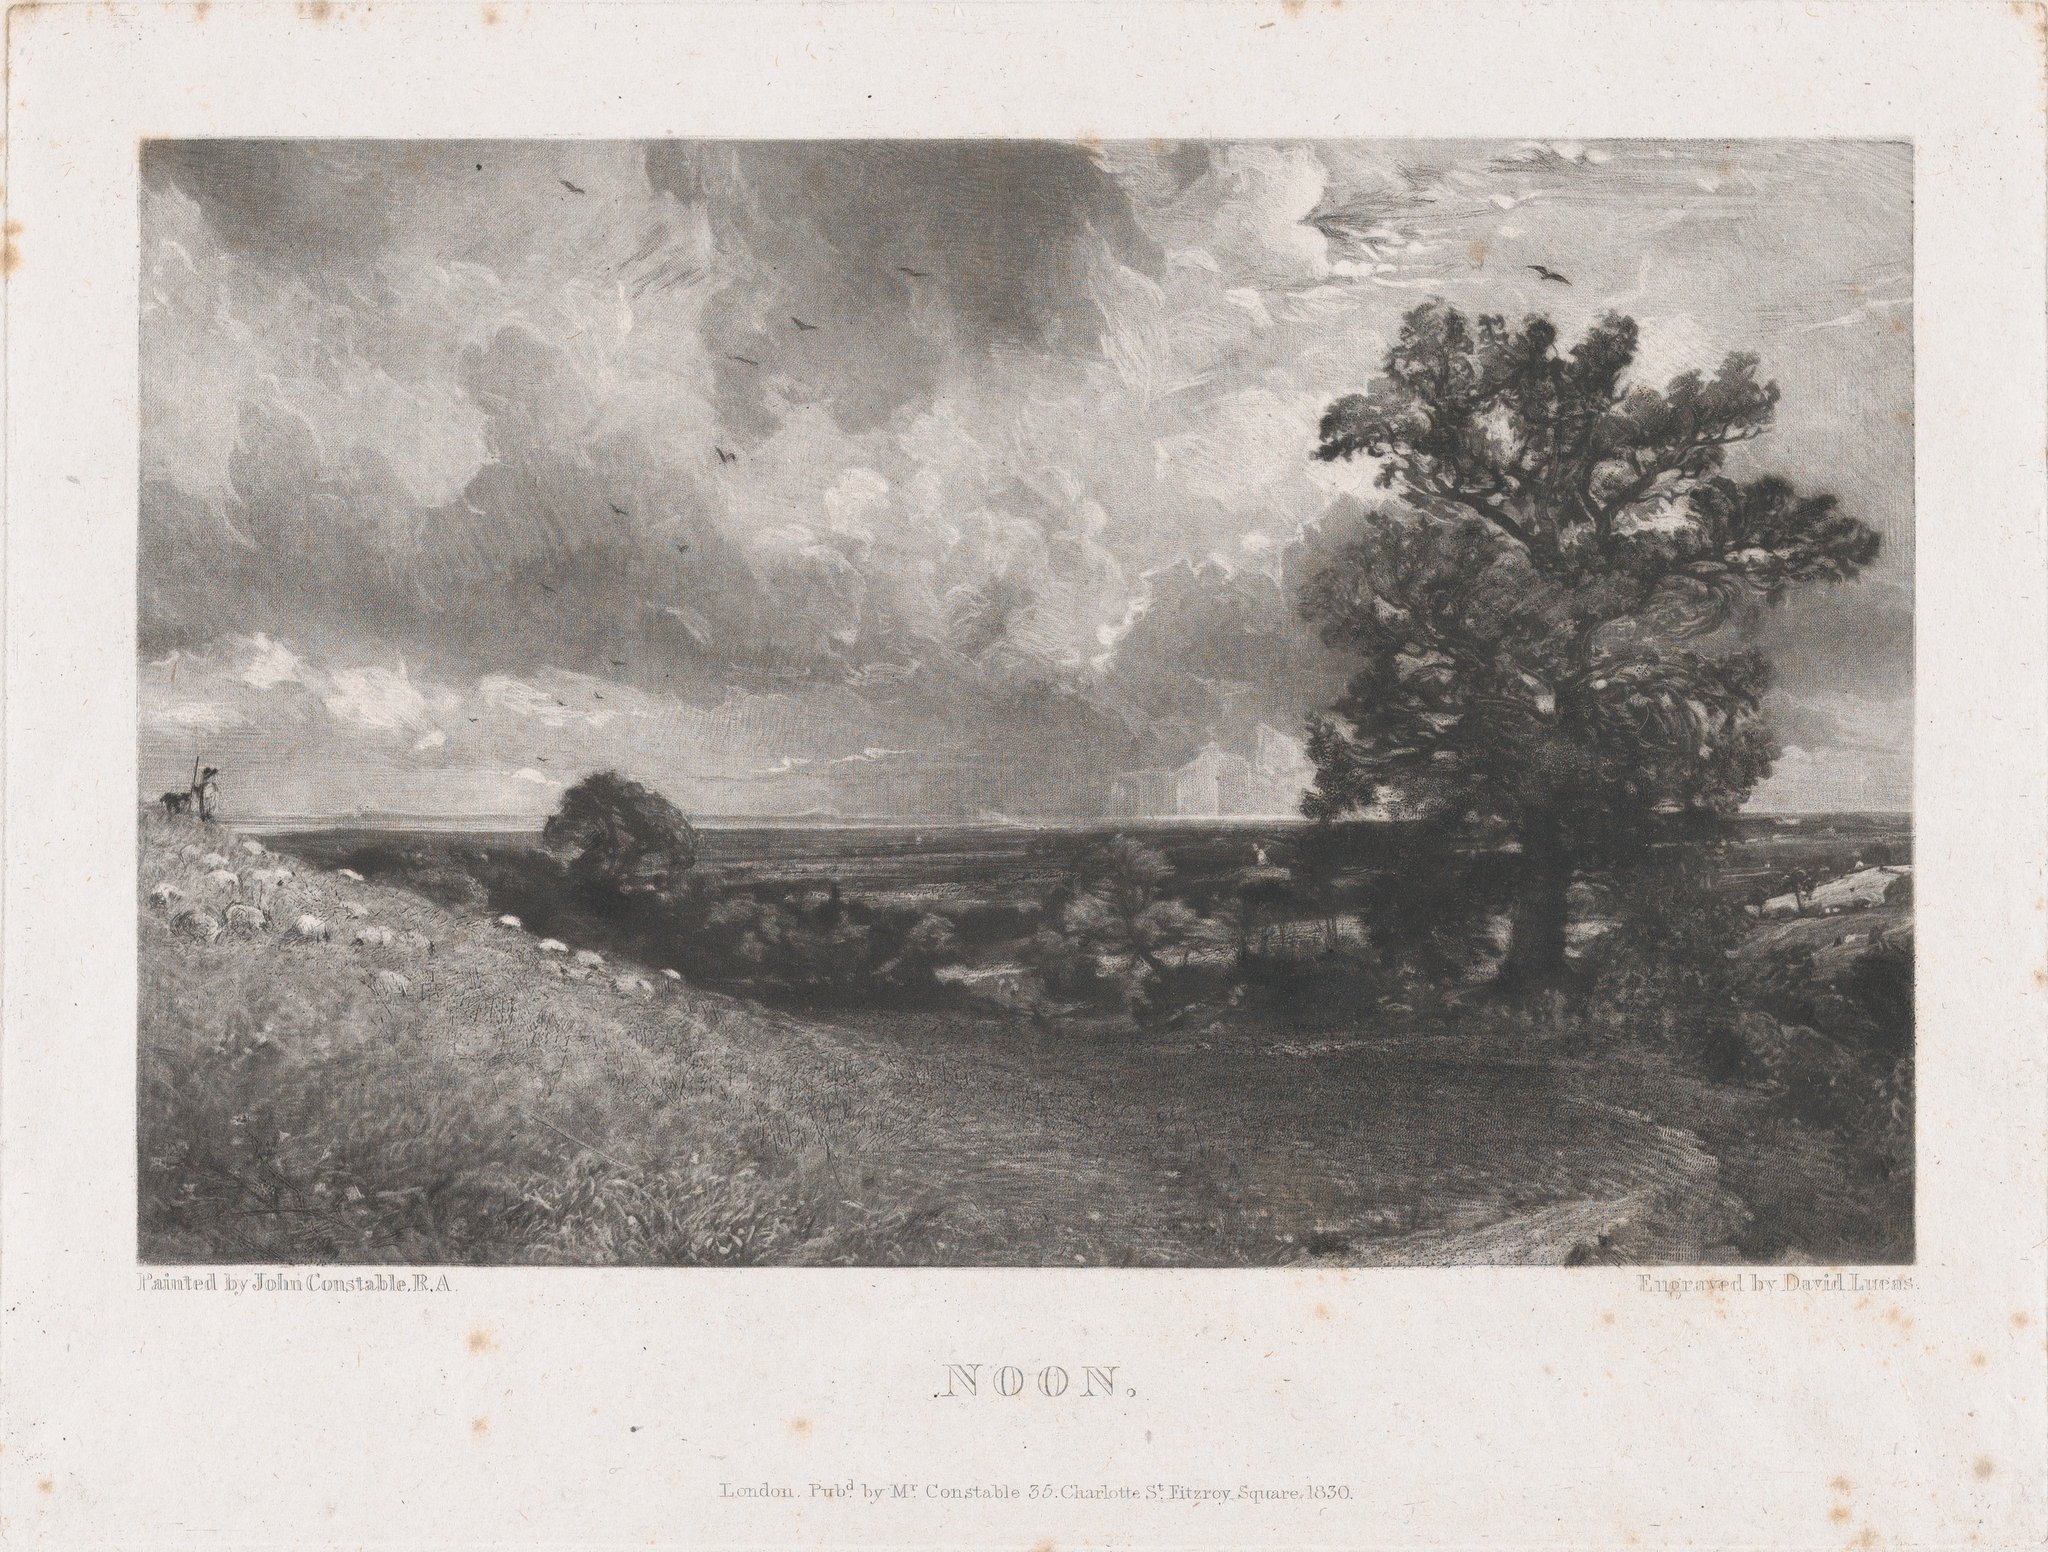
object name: print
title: Noon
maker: david lucas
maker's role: artist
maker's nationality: british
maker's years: 1802-1881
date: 1830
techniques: mezzotint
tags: landscapes